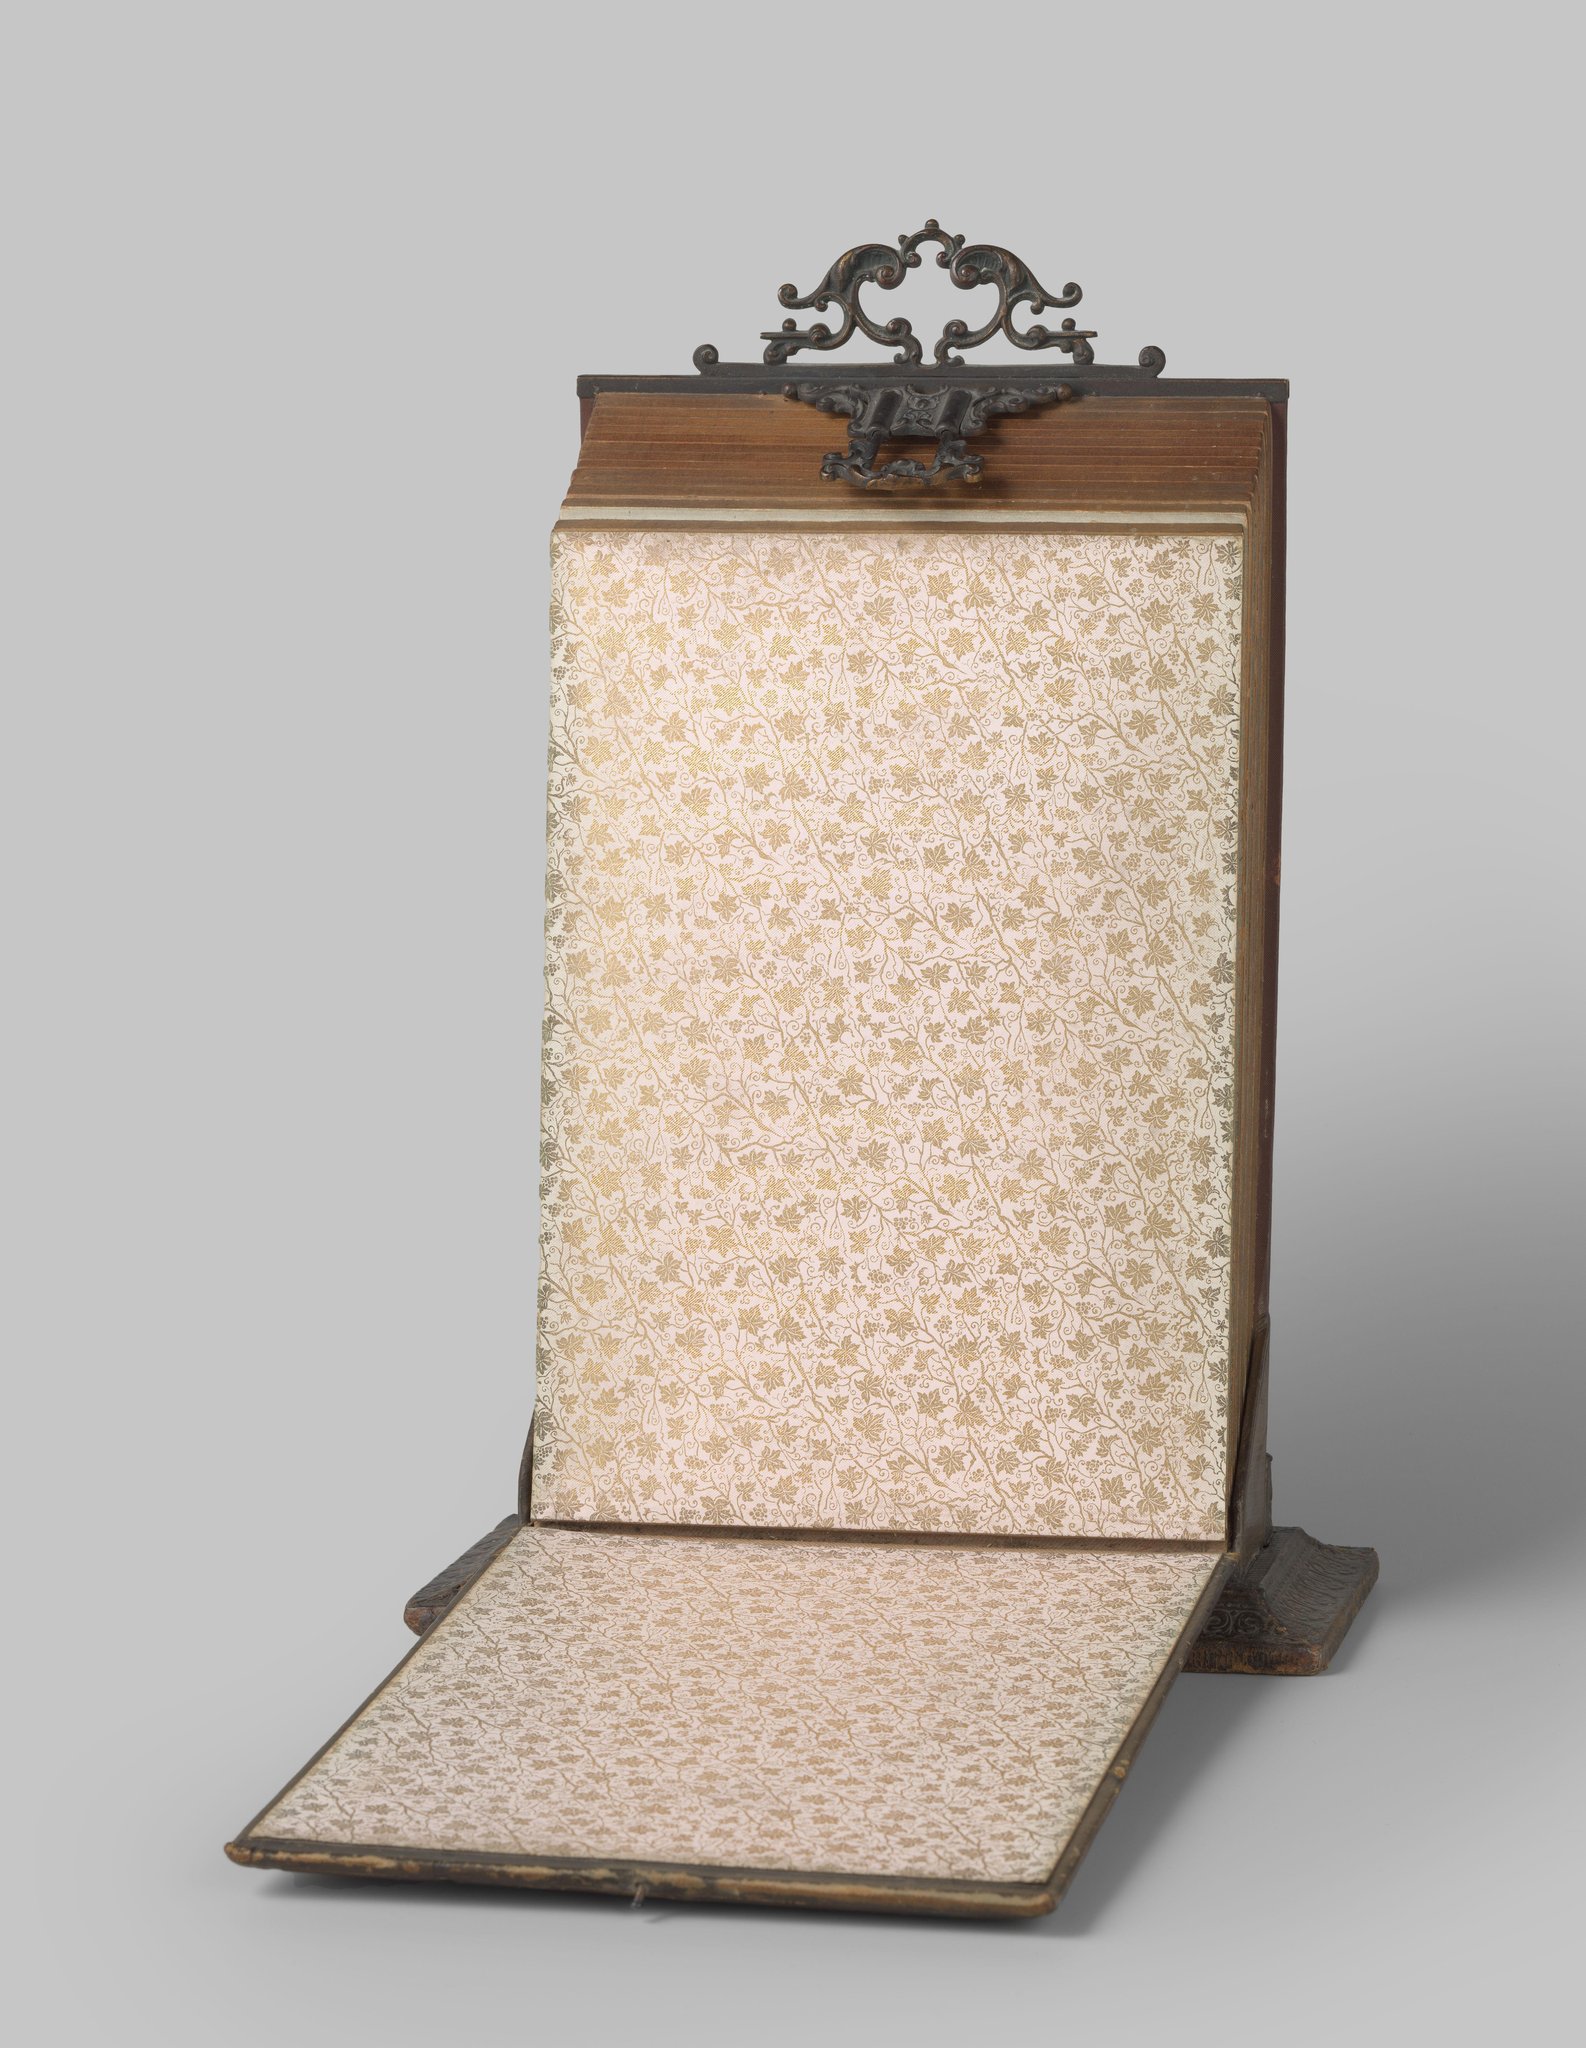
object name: slip in album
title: Engels familiealbum met 18 foto's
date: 1860-1900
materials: cardboard, leather, metal, paper, photographic support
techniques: albumen print, chromolithography, decorated paper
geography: england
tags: historical persons - bb - woman, child, historical persons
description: Fotoalbum met in totaal 18 foto's op 26 pagina's. Het album bevat 18 kabinetfoto's in met gouden lijnen of afbeeldingen in chromolithografie omkaderde passe-partouts. Afgebeeld zijn portretten van onbekende mannen, vrouwen en kinderen. De foto's zijn gemaakt door verschillende Engelse fotografen, waaronder Henry Thomas Edwards. Van 2 foto's is de fotograaf anoniem.